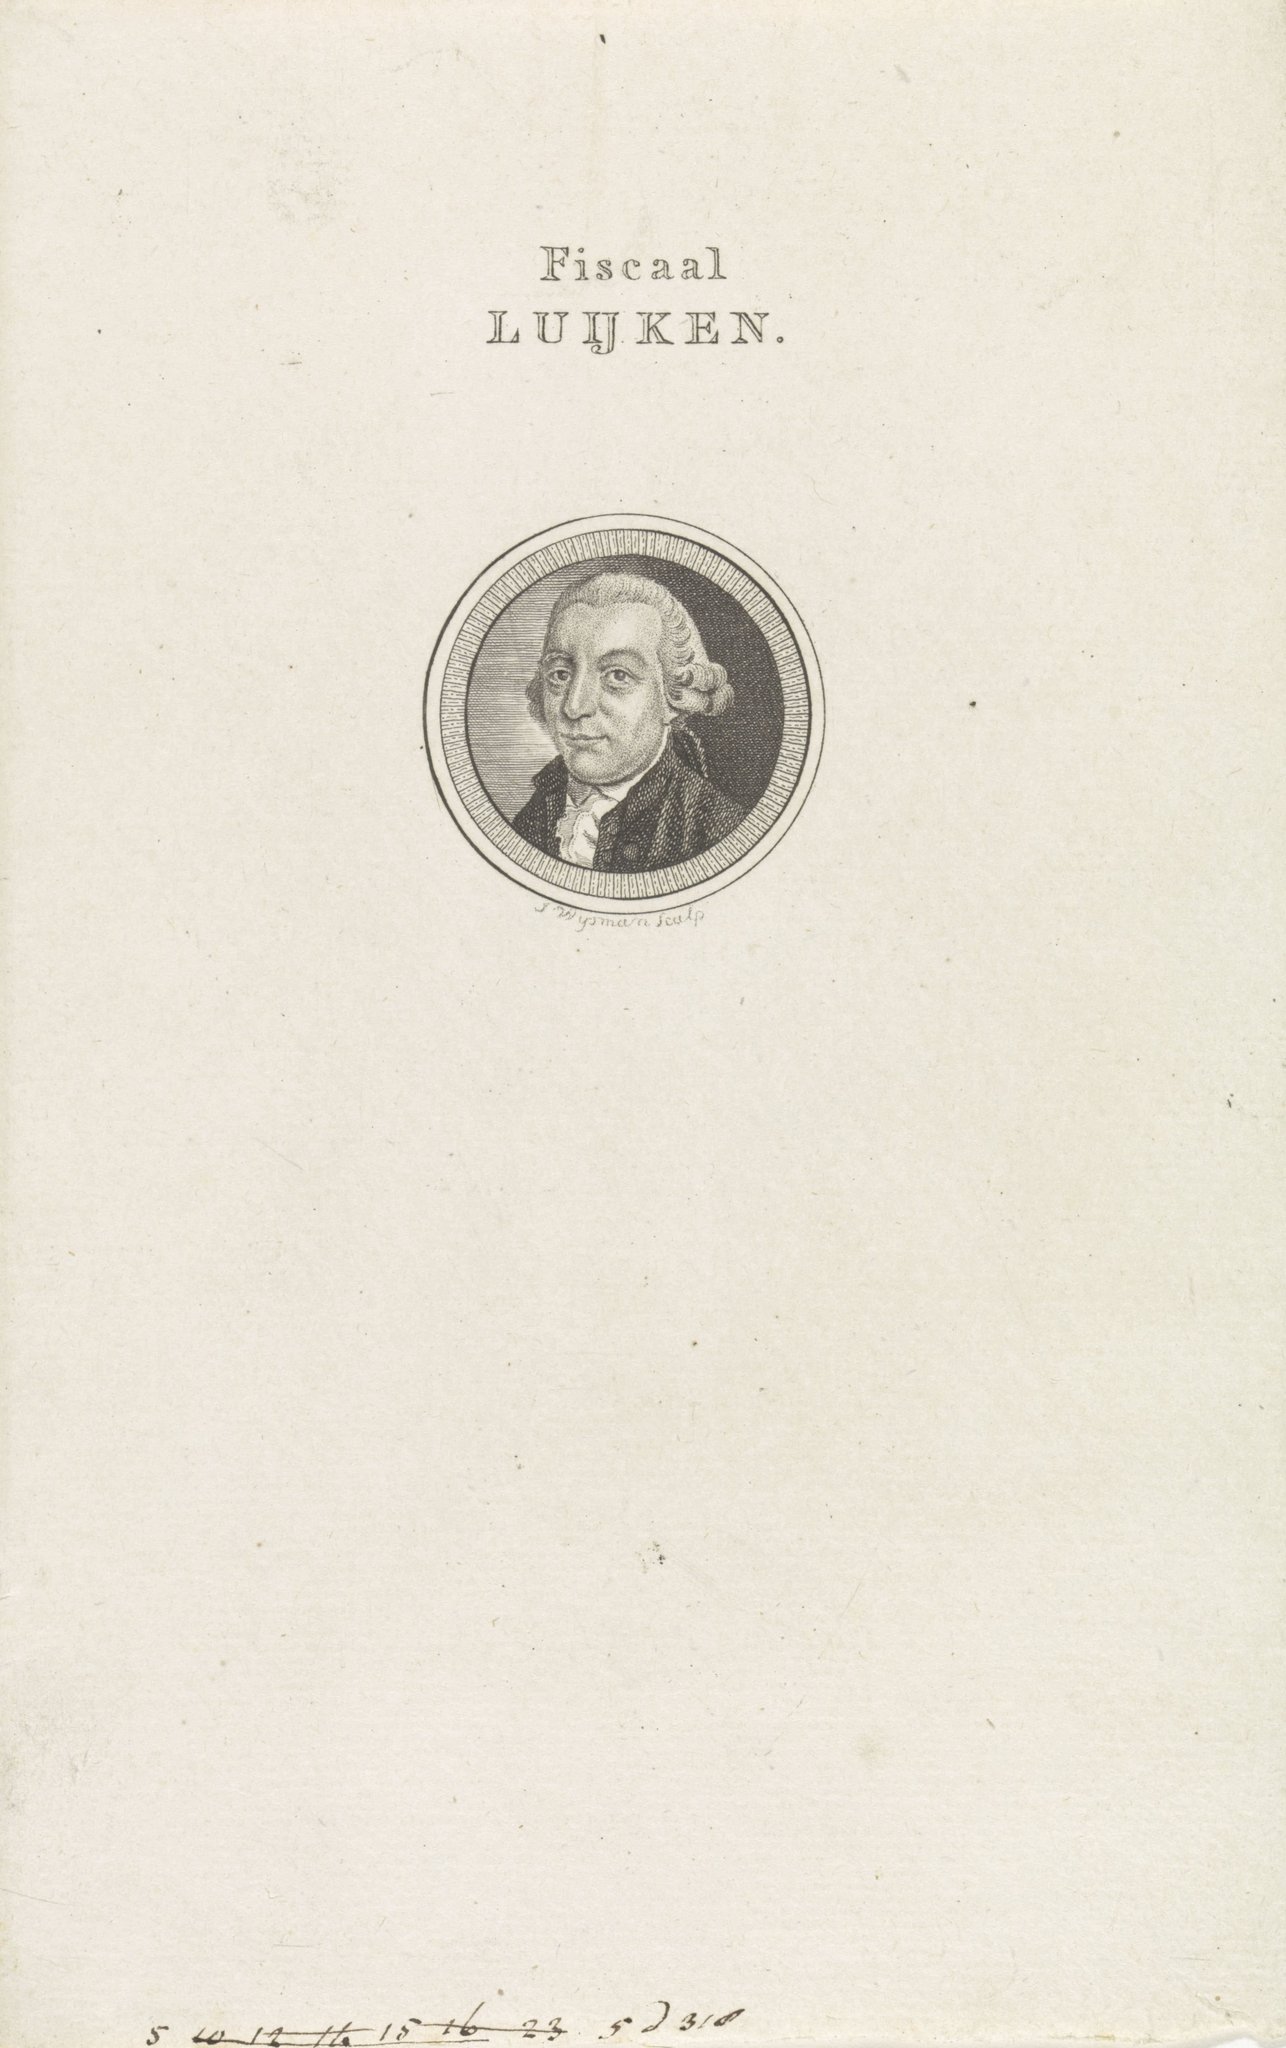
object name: print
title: Portretten van patriotten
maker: jacobus wijsman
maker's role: print maker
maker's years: 1768-1827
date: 1794-1796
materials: paper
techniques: engraving, etching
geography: amsterdam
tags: haarlem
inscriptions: collector's mark: Lugt 2228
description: Portret van patriot Johannes Gerardus Luyken in een medaillon.